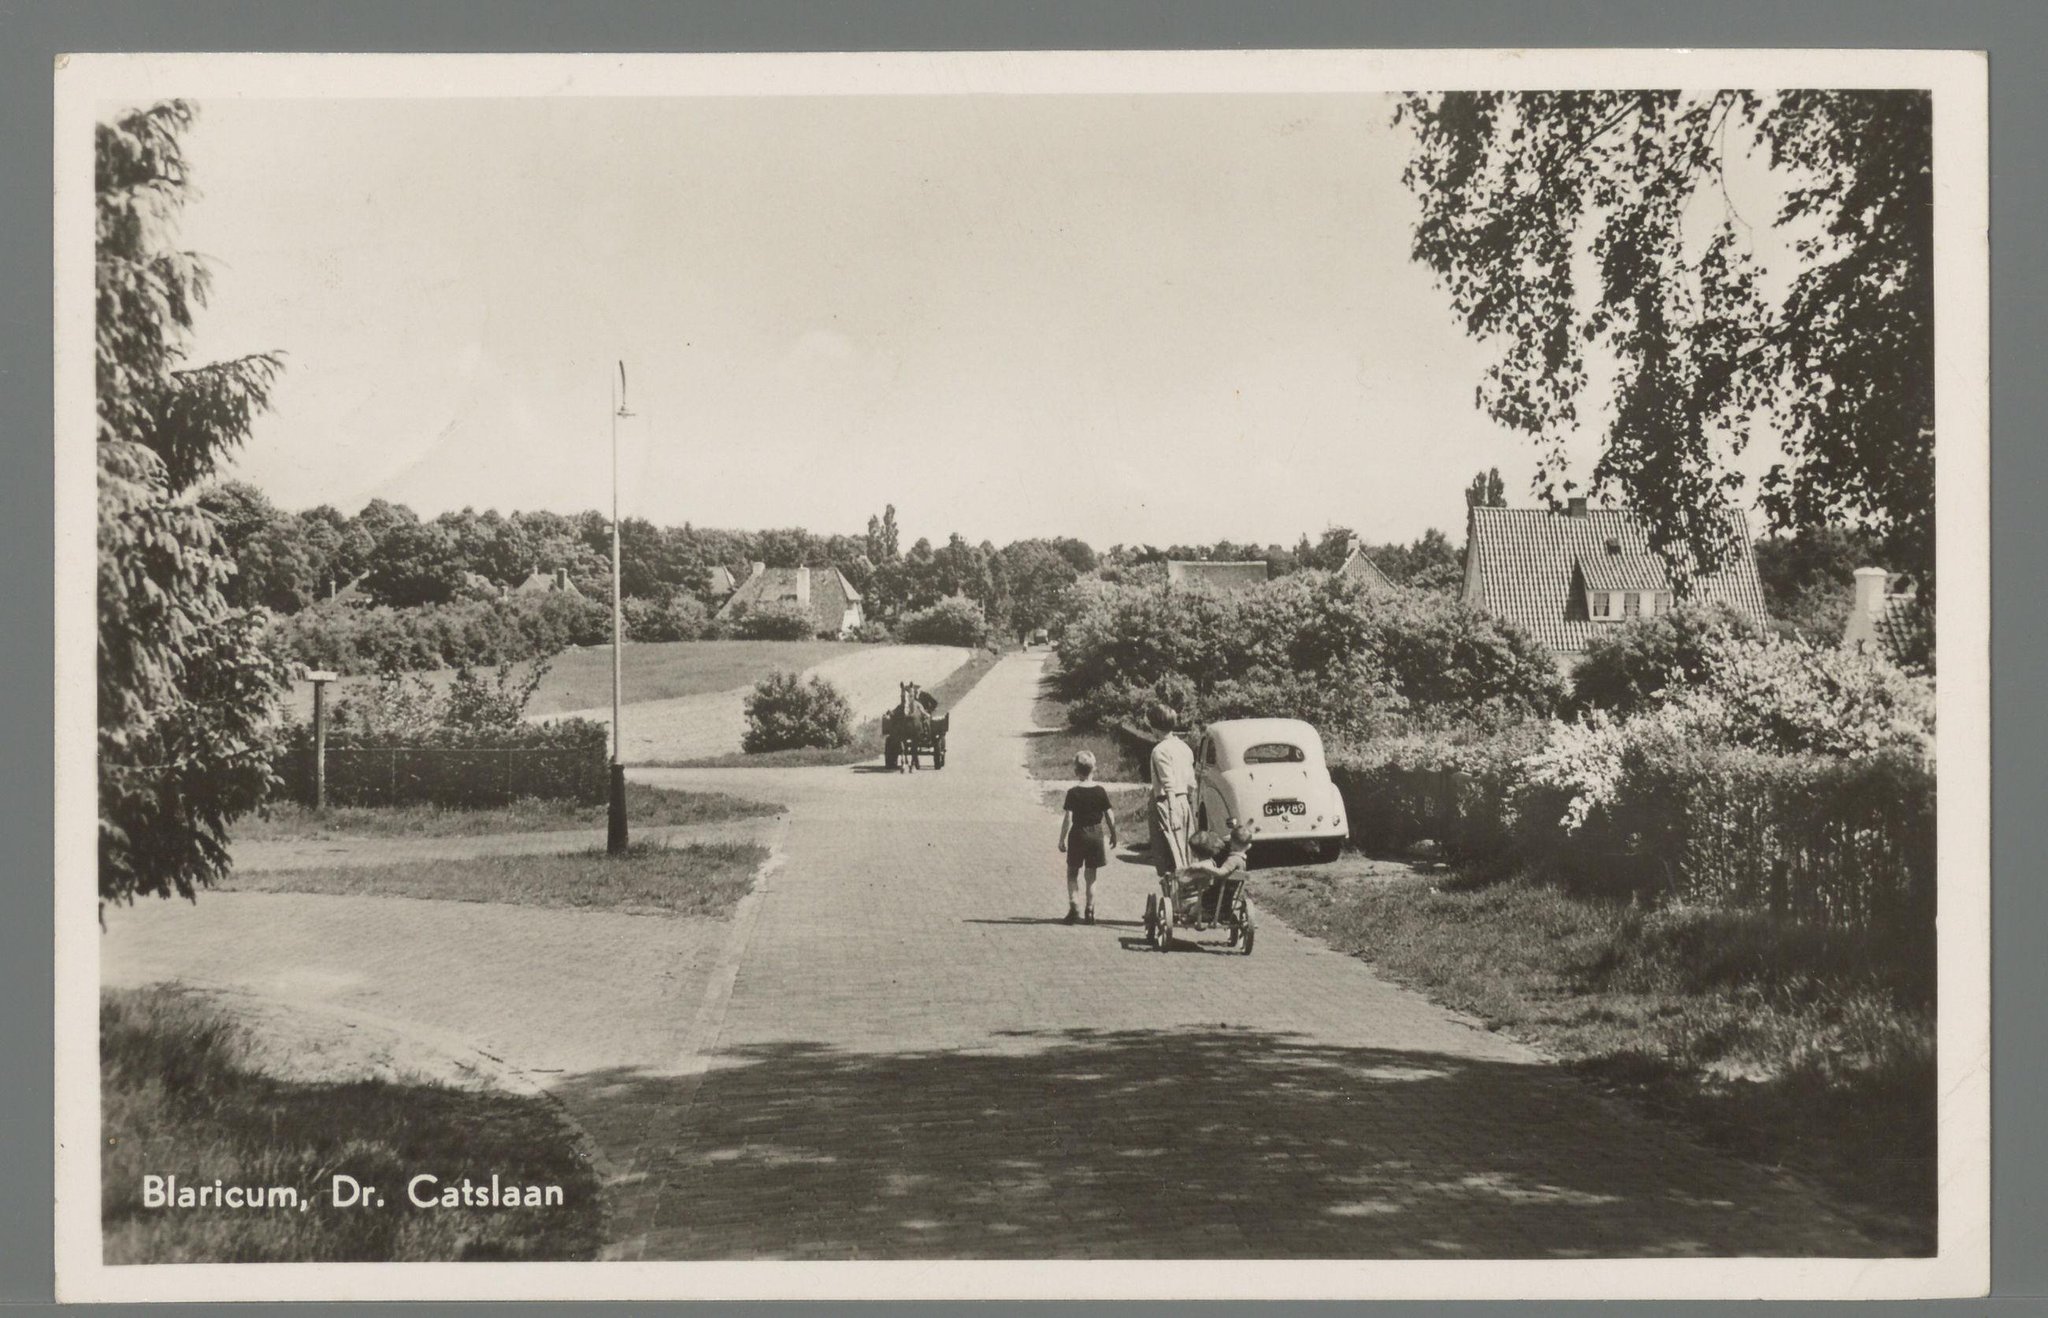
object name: ansichtkaart, prentbriefkaart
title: Blaricum, Dr. Catslaan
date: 1929-1951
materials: photographic support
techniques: photography, writing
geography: blaricum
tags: city-view, and landscape with man-made constructions, automobile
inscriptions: postage stamp